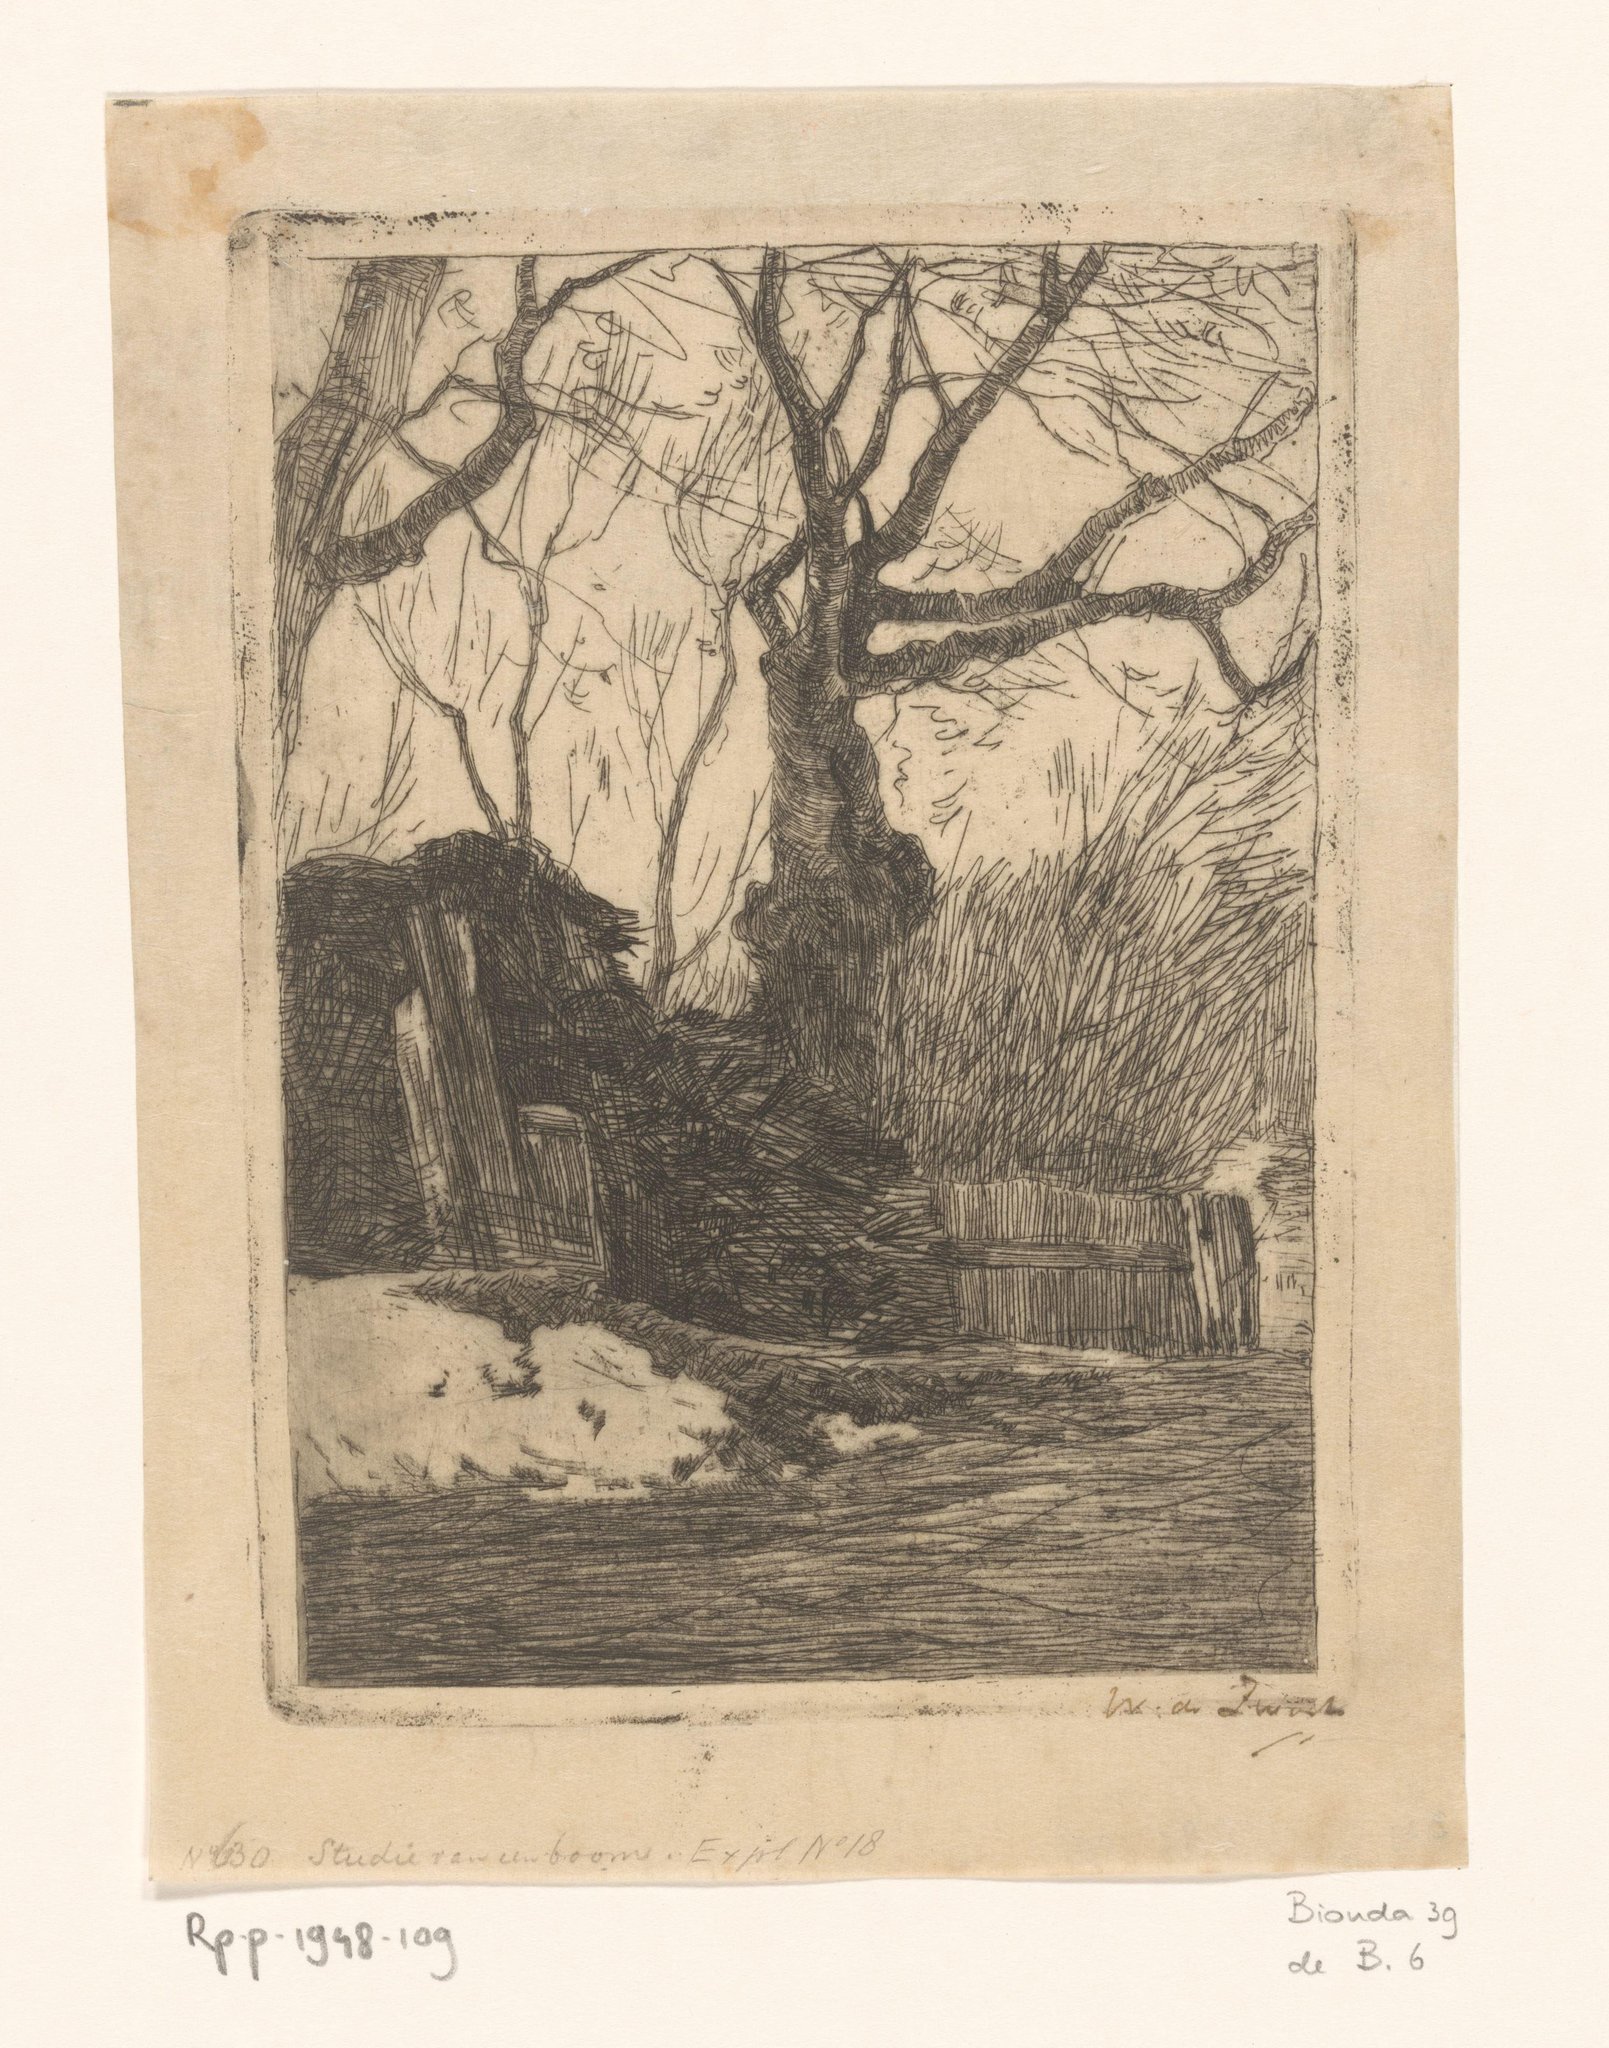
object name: print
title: Bomen en takkenbossen bij een hek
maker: willem de zwart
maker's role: draughtsman, painter, print maker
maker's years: 1862-1931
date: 1889-1890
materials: paper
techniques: drypoint, etching, intaglio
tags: trees, fence, wall, paling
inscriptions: collector's mark: Lugt 2228